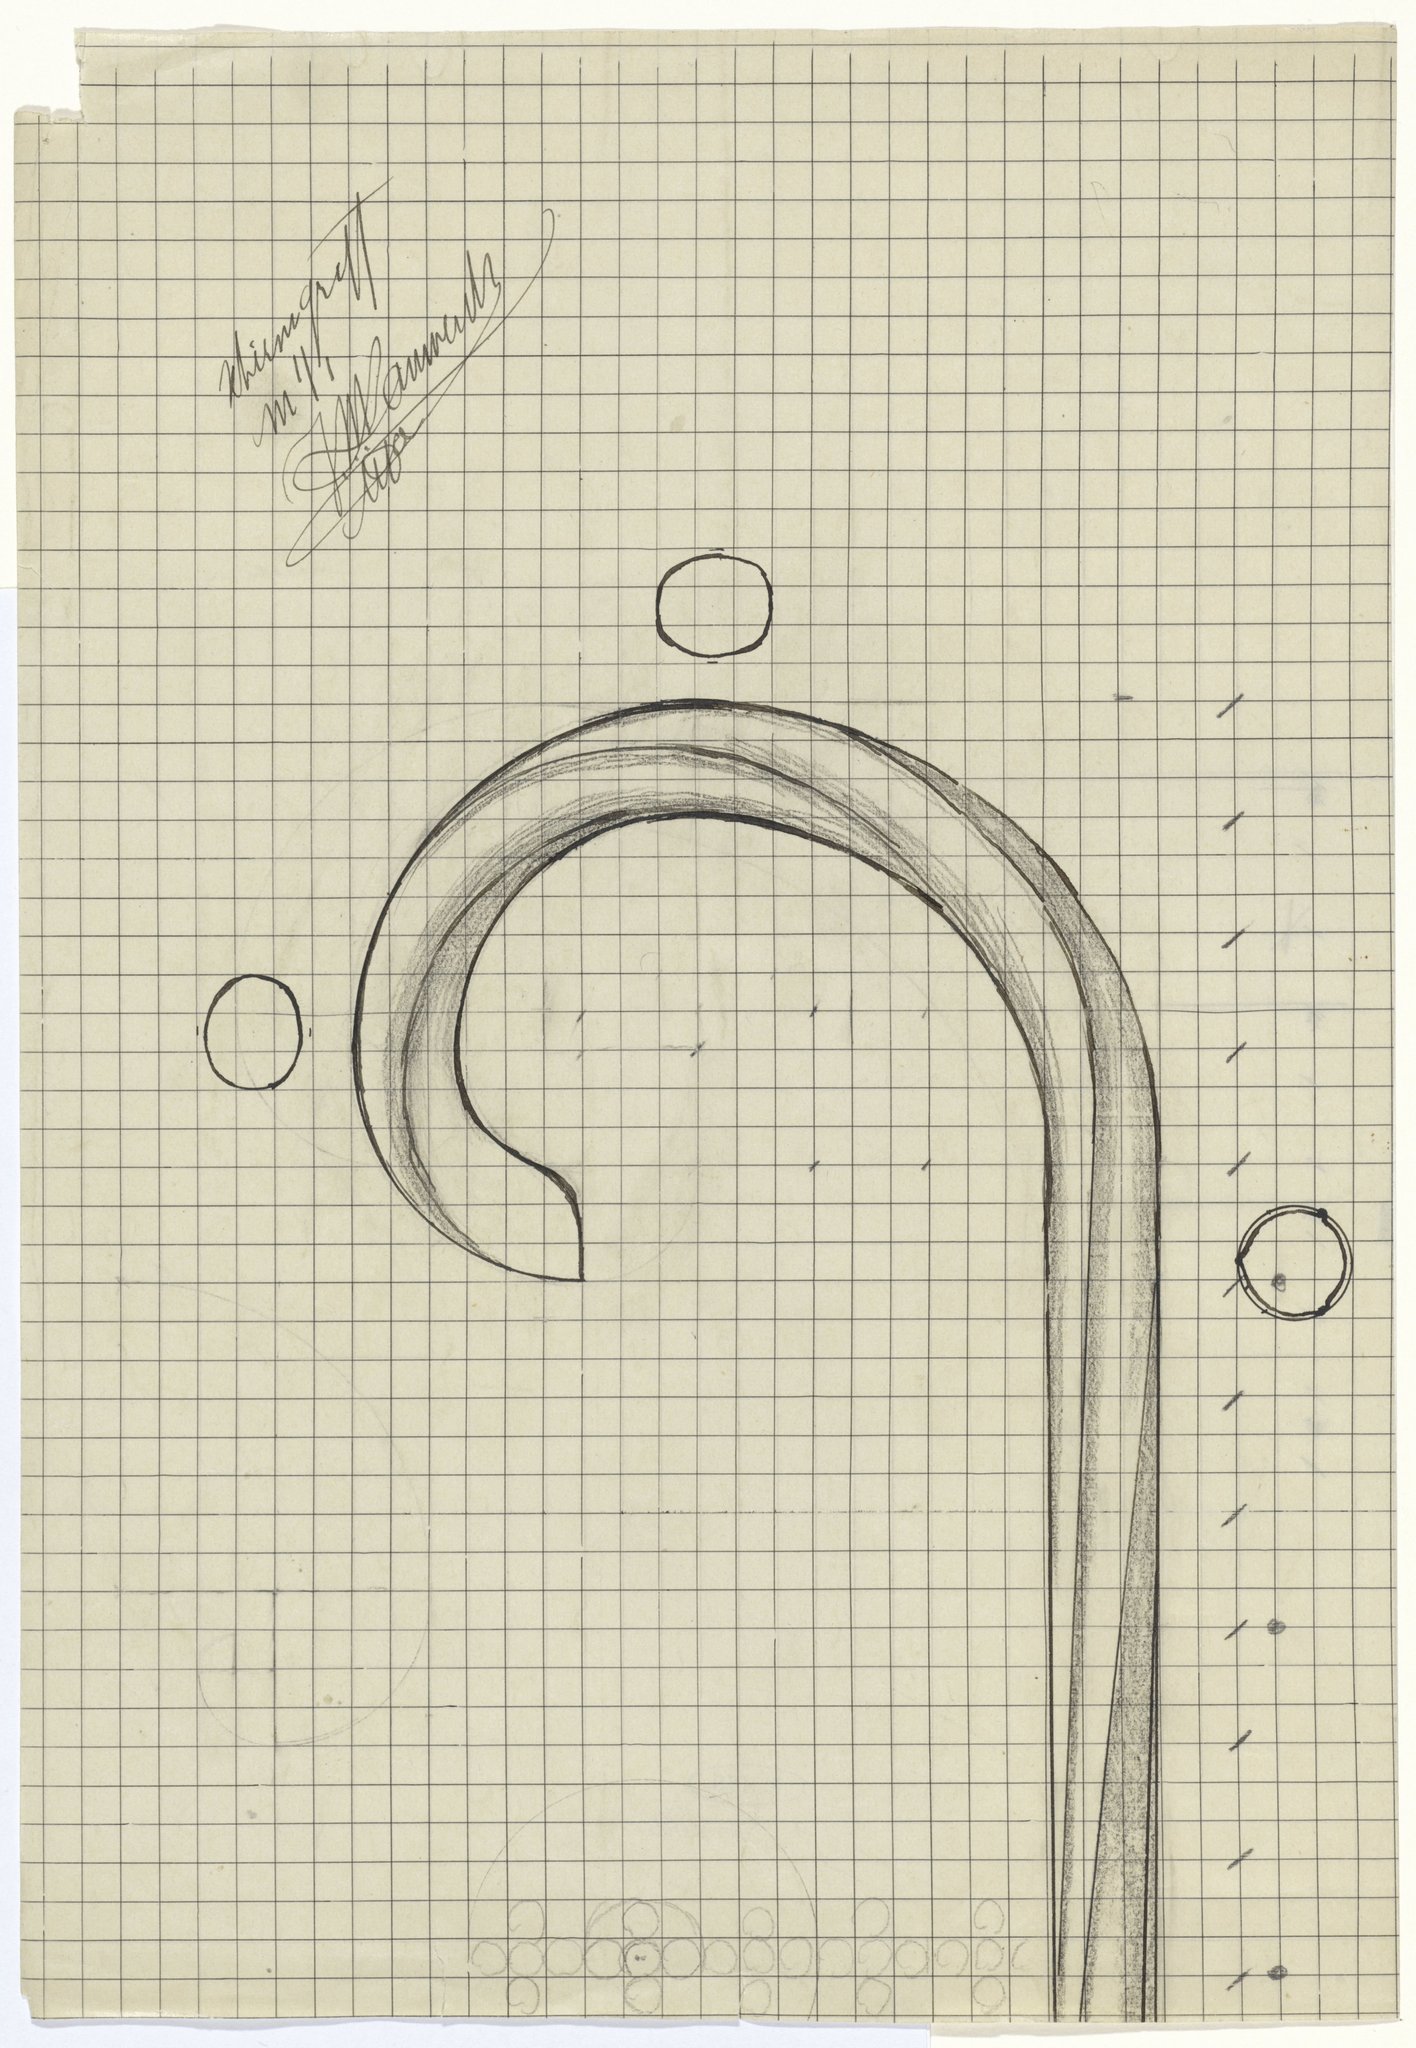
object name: drawing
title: Ontwerp voor de haak van een paraplu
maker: mathieu lauweriks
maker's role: designer, draughtsman, print maker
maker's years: 1864-1932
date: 1874-1932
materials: chalk, ink, pencil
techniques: pen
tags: umbrella